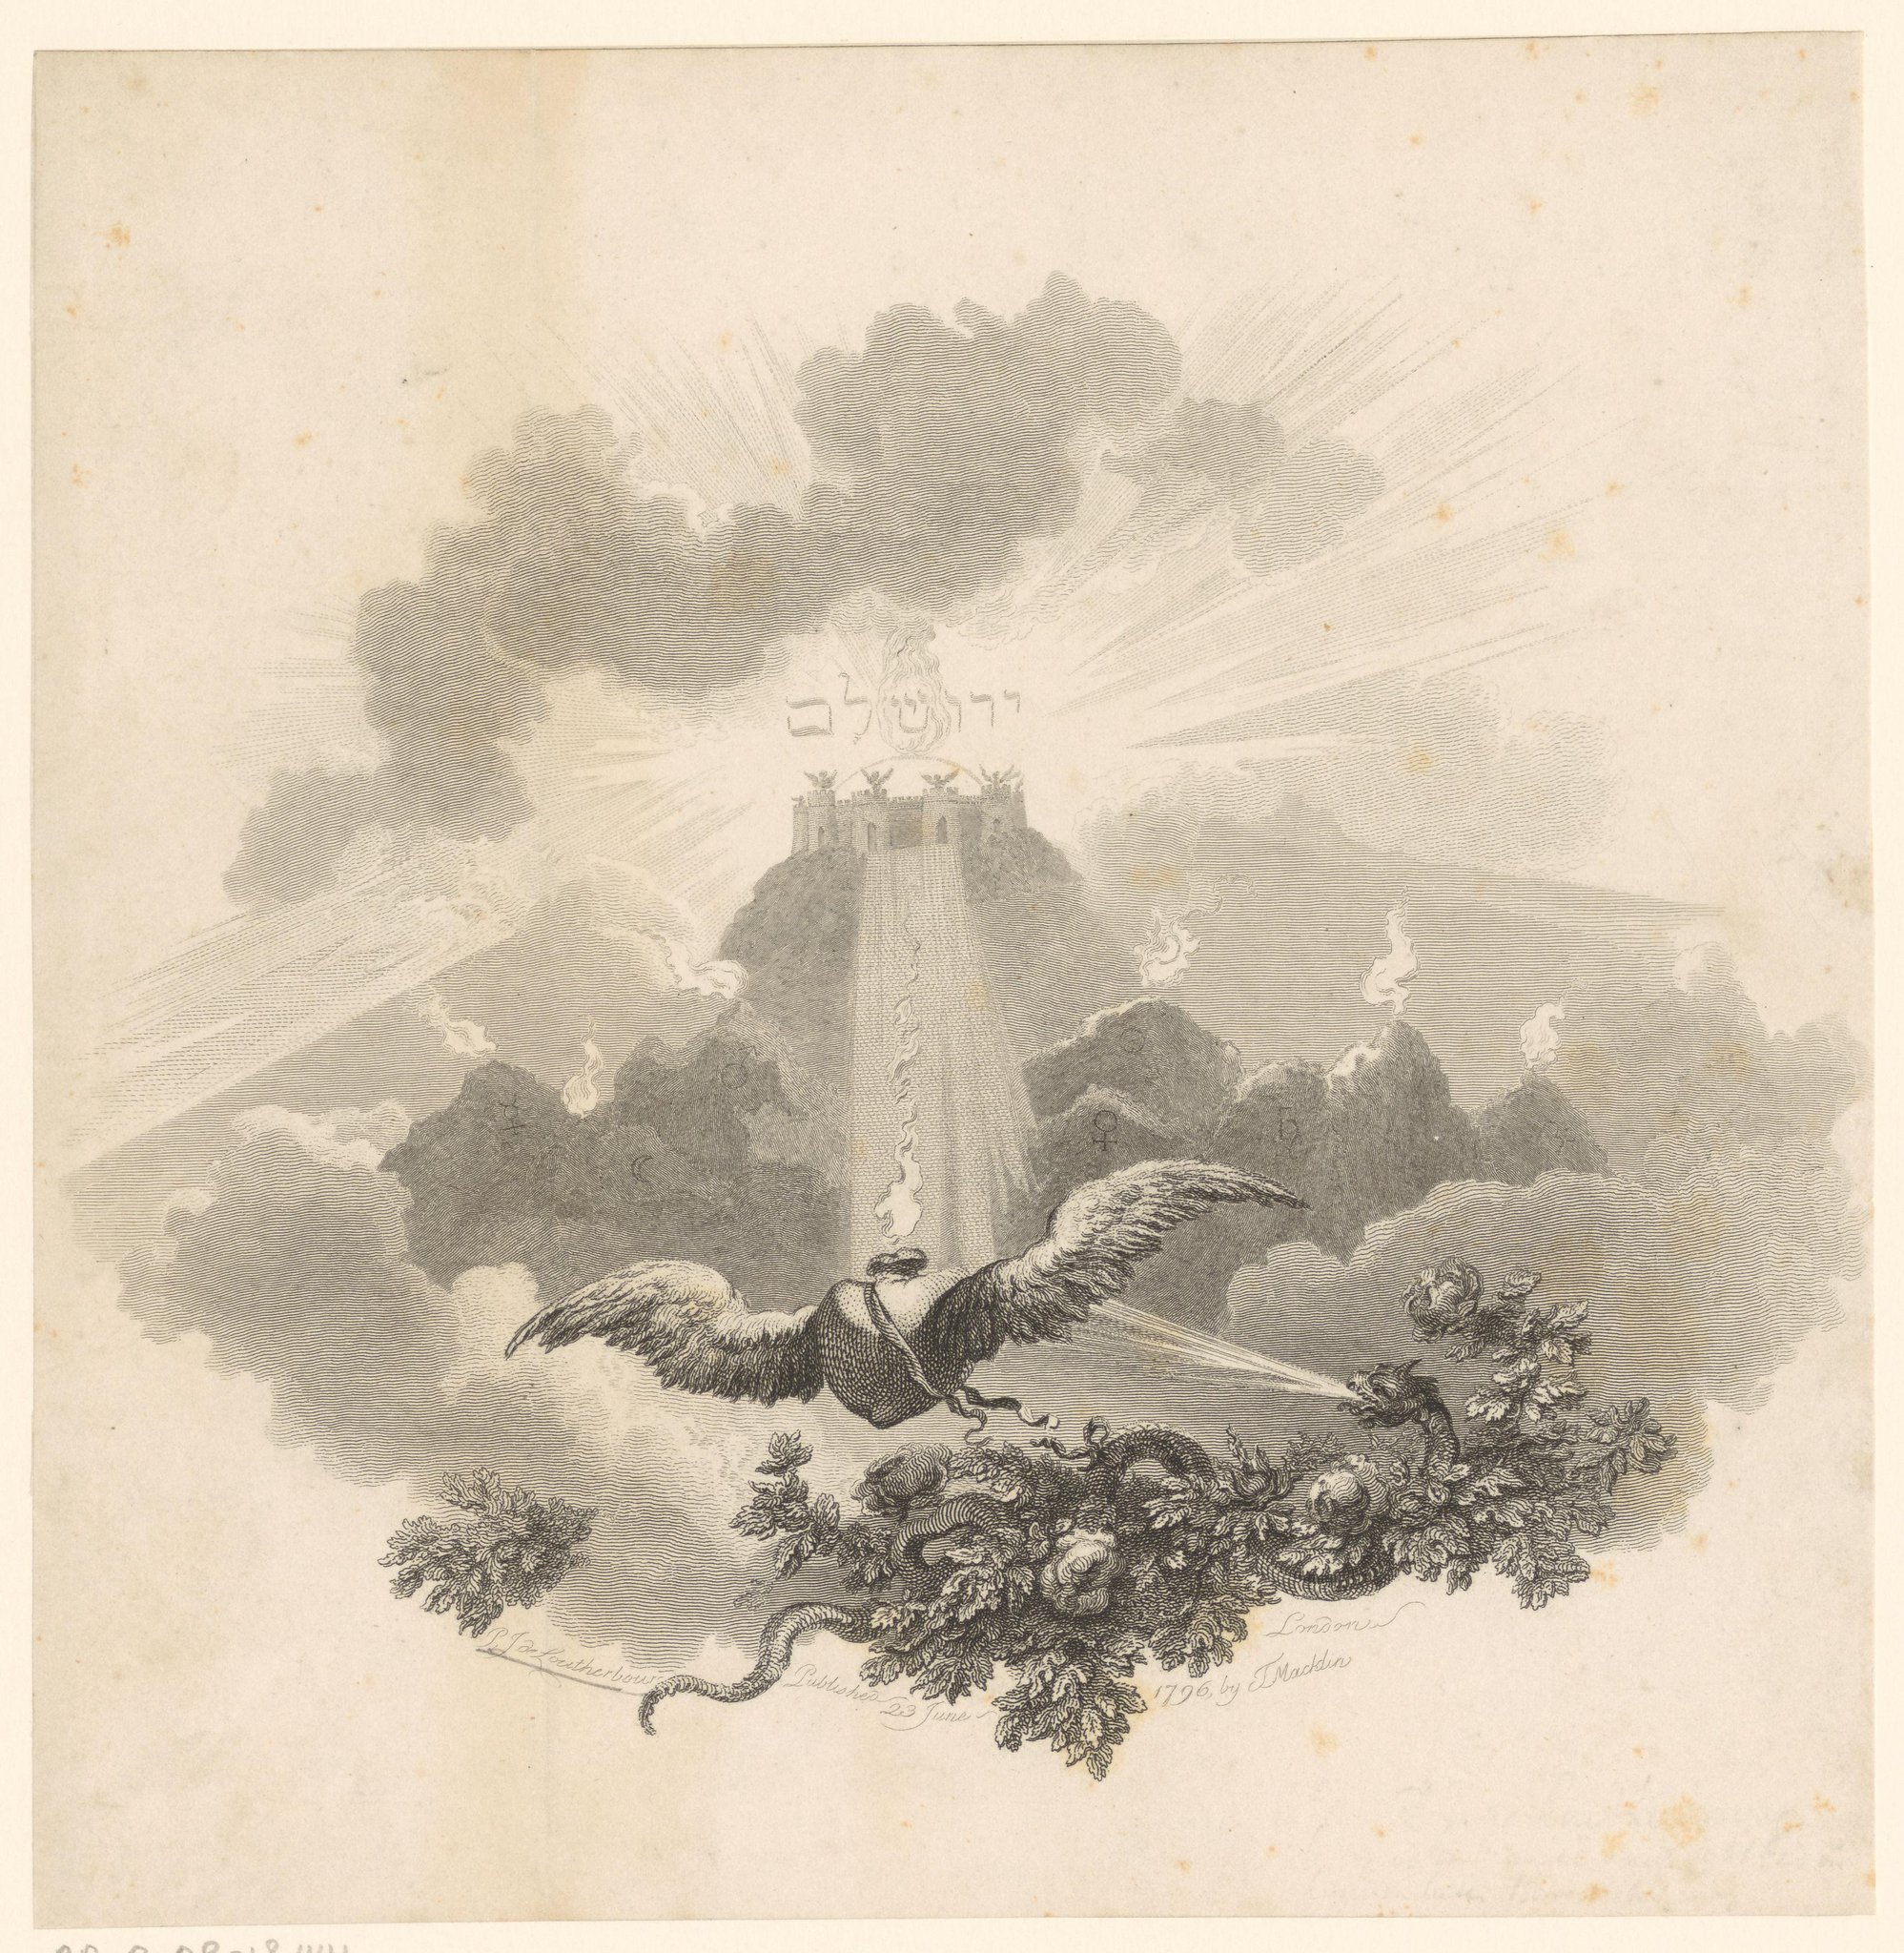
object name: print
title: Gevleugeld hart stijgt op naar een hemels fort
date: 1706-1796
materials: paper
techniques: etching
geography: england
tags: heaven represented as a city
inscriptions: collector's mark: Lugt 2228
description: Prent is vermoedelijk als illustratie gebruikt voor Macklin's Bible, in delen gepubliceerd tussen 1789 en 1800.